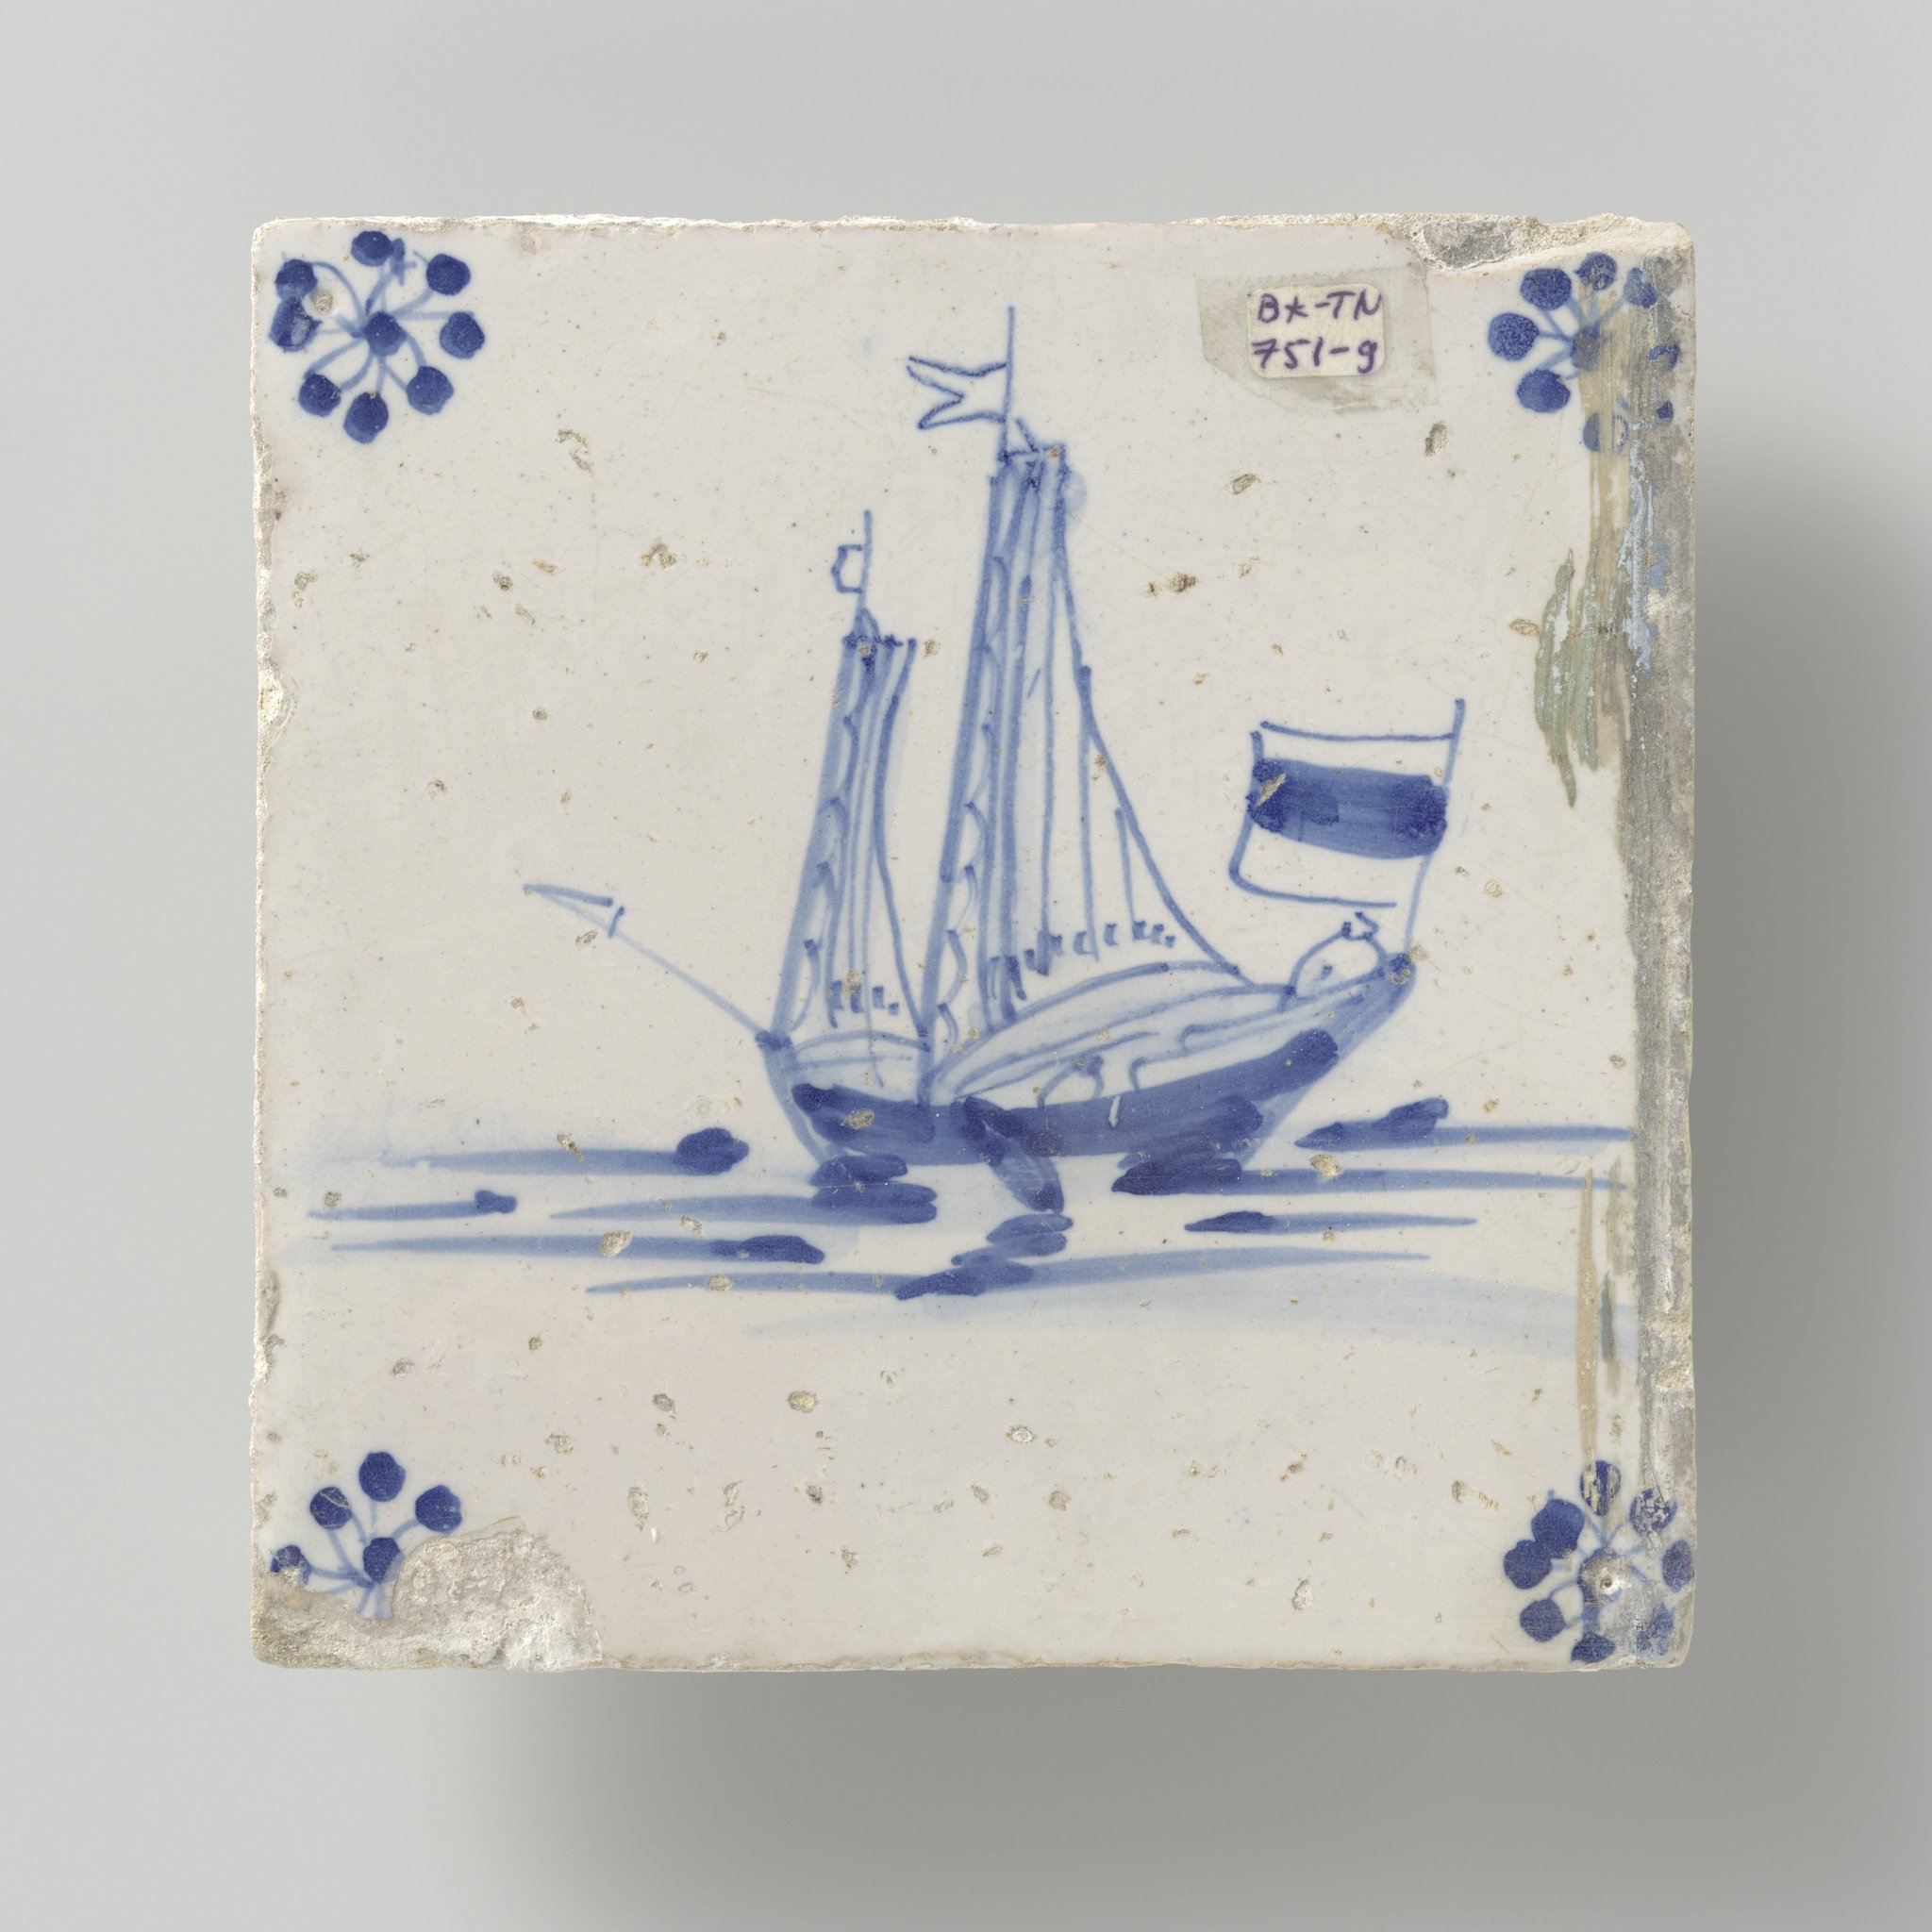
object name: tile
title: Tegel, blauw beschilderd met een schip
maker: Anonymous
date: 1650-1680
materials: earthenware, glaze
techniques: maiolica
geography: netherlands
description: Tegel, blauw beschilderd met een schip, zogenaamd boerenscheepje. In de hoeken een spinnekop.